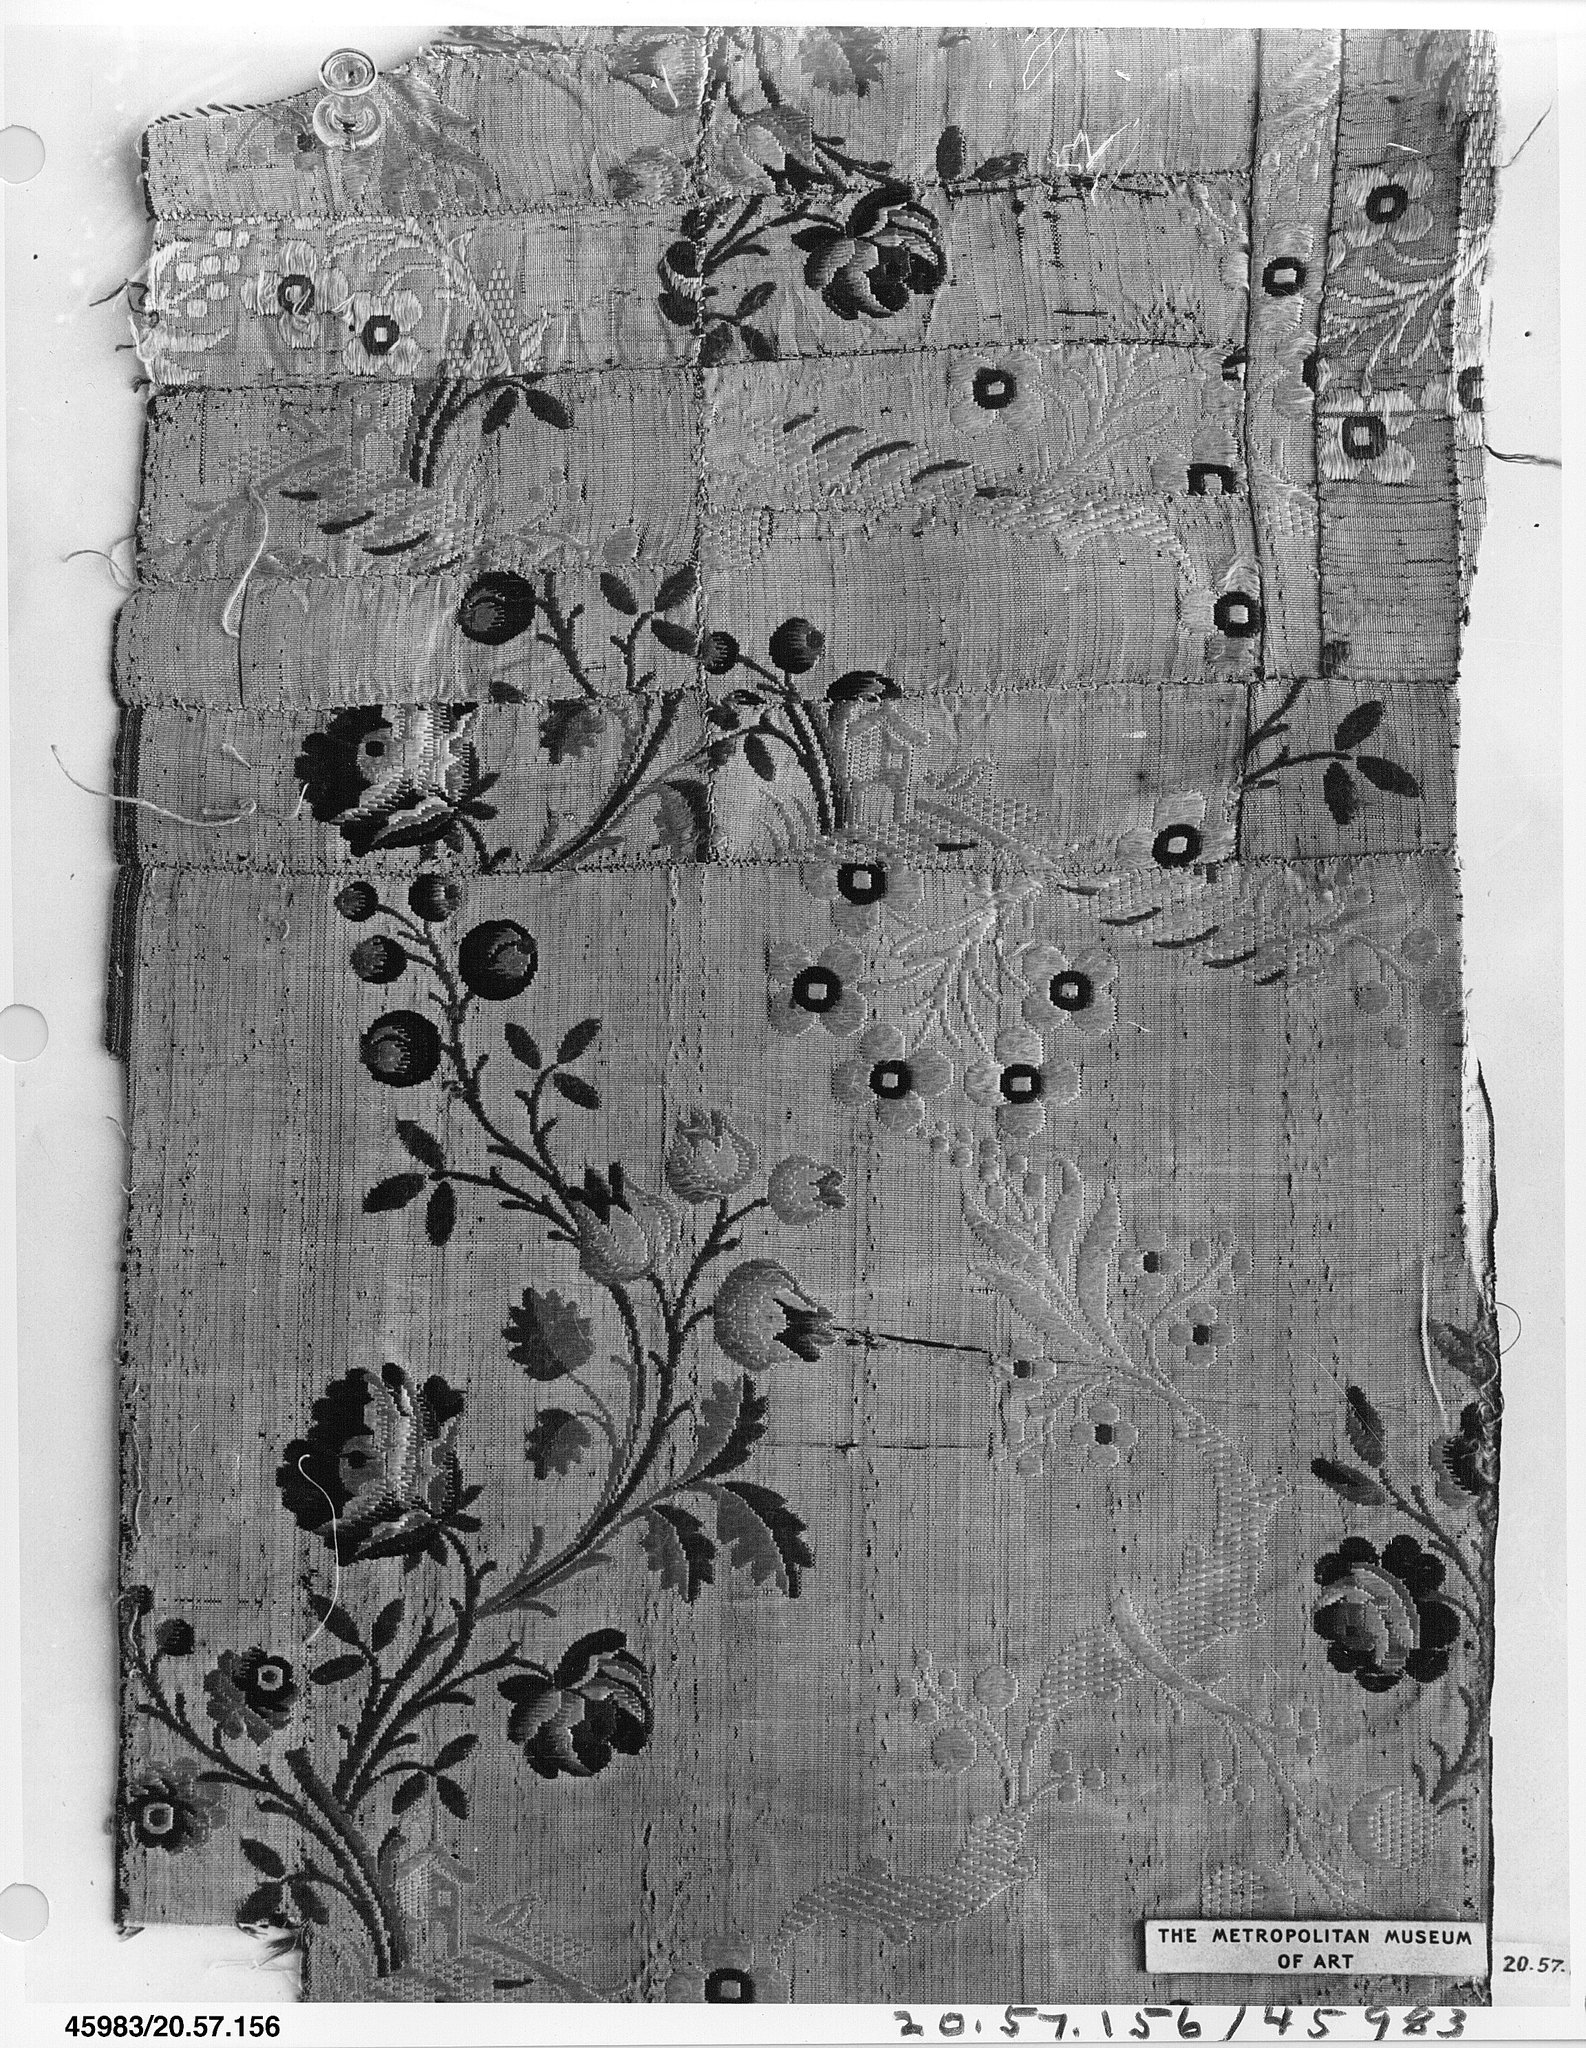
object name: piece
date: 1750-1760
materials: silk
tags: flowers,leaves